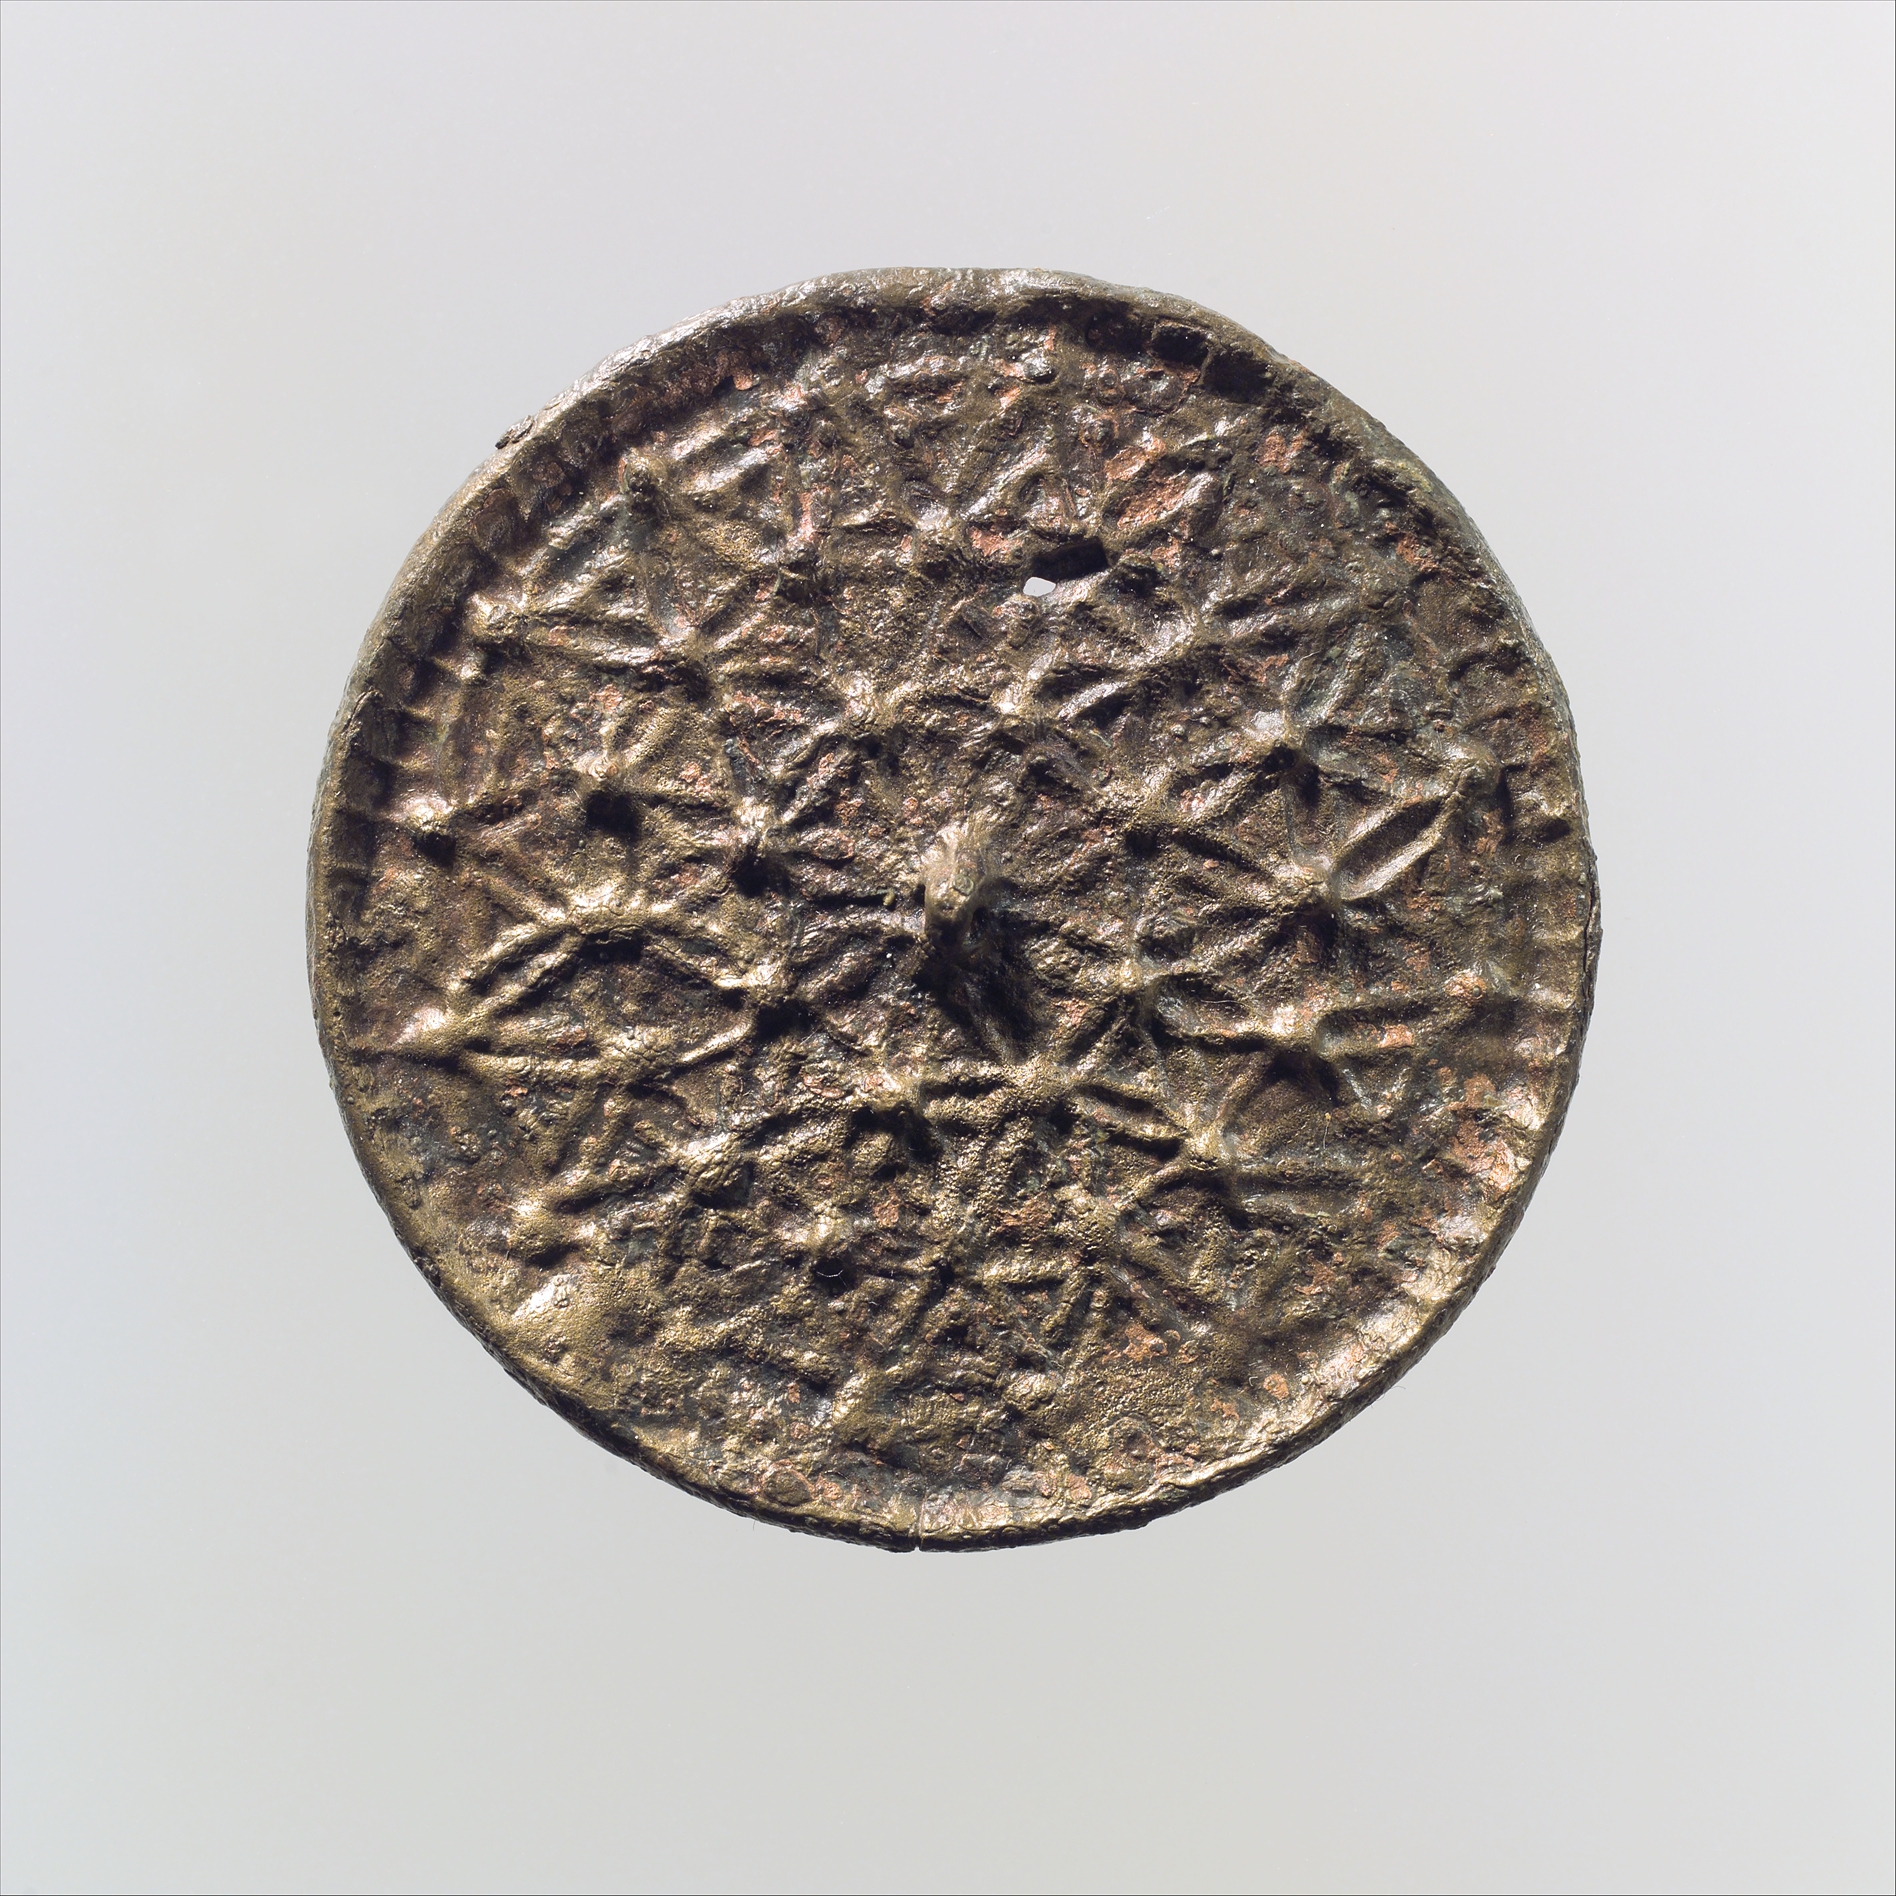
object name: mirror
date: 1101-1300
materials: bronze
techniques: casting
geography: iran